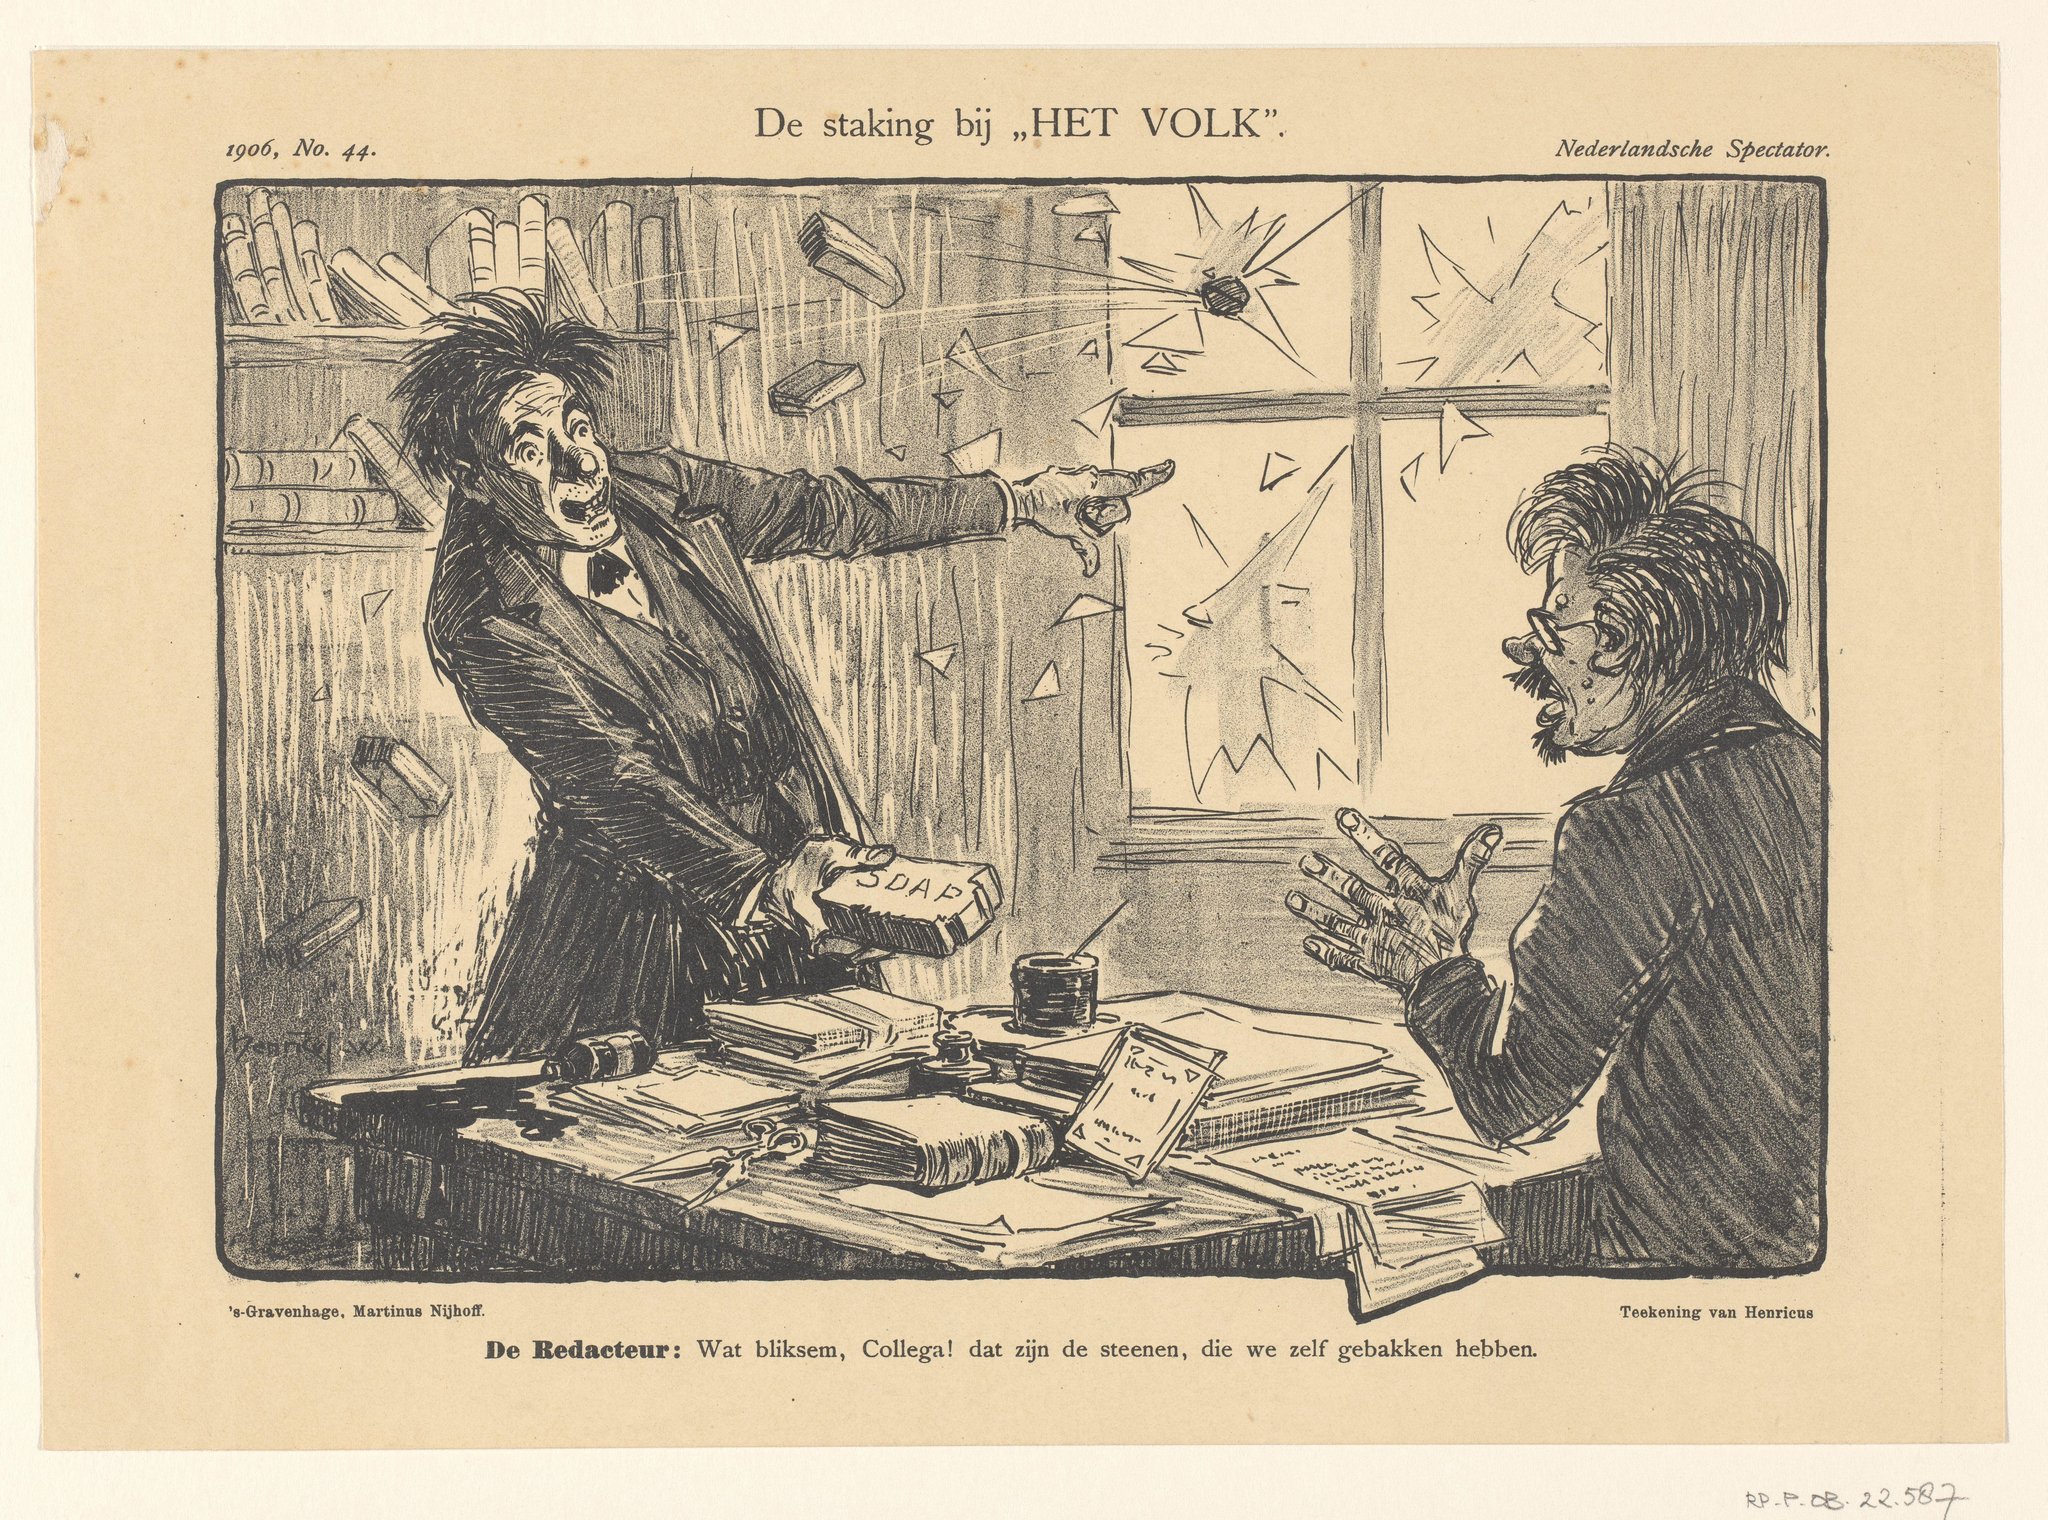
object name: print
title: Spotprent op de staking bij socialistisch dagblad Het Volk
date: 1906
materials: paper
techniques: lithograph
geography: the hague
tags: window, editorial board, political caricatures and satires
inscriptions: collector's mark: Lugt 2228a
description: Twee redacteuren in een kantoor van Het Volk dat bekogeld wordt met bakstenen. De ruit van het kantoor is gesneuveld en één van de redacteuren houdt een baksteen vast met daarop 'SDAP', de afkorting van de Sociaal-Democratische Arbeiderspartij.